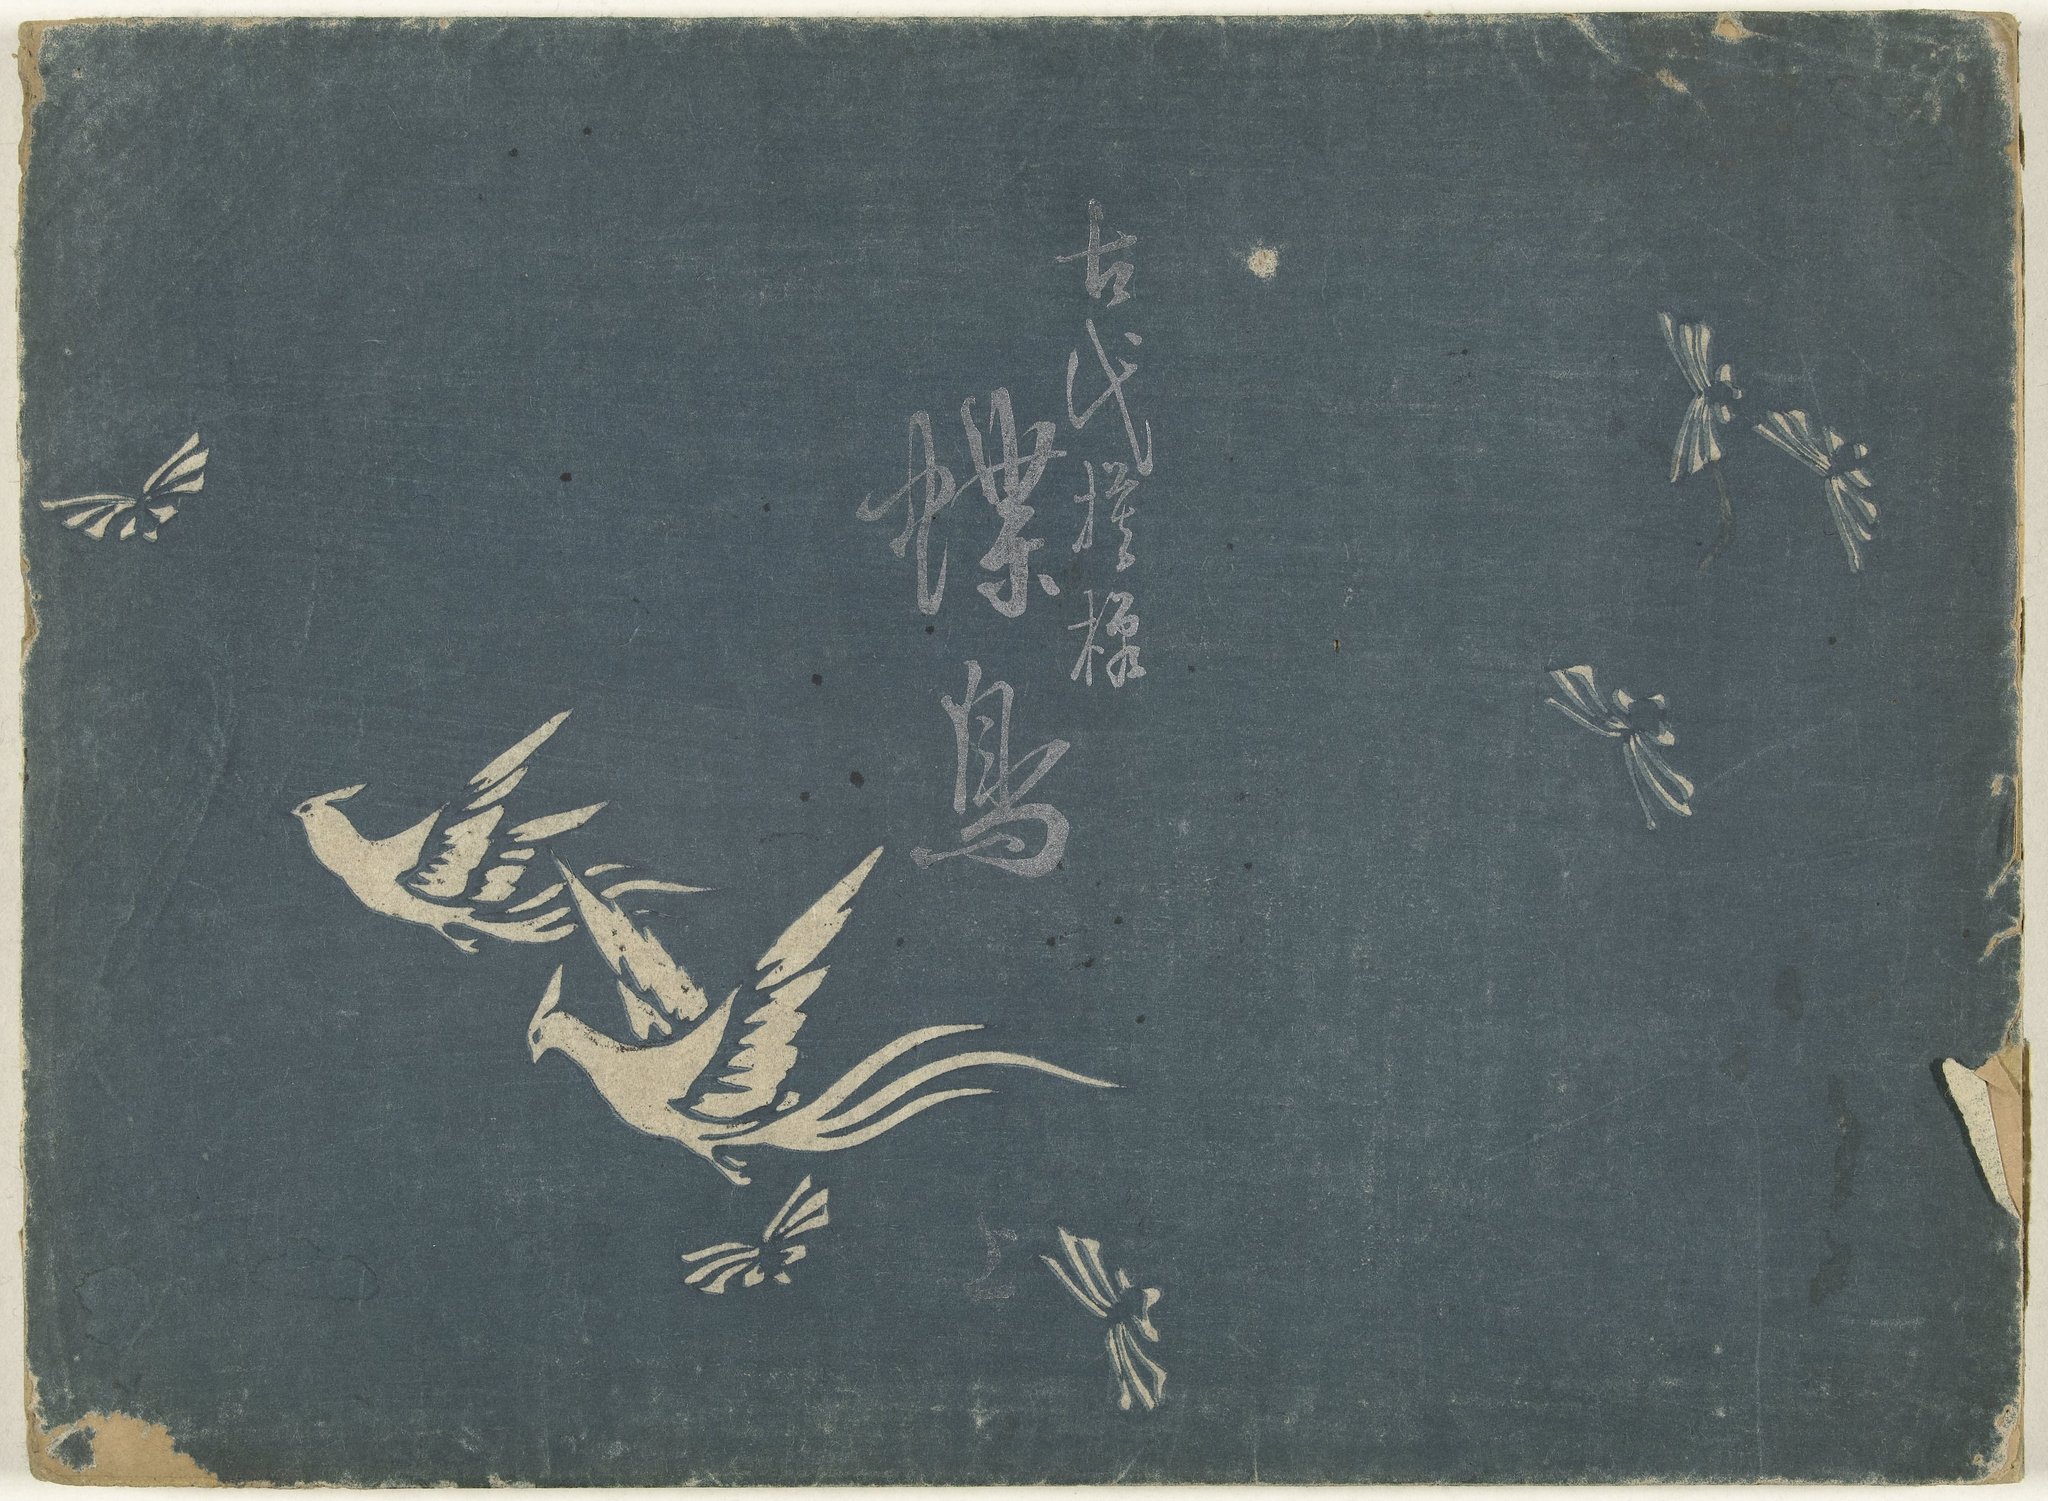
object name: book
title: Vogels en vlinders- deel één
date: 1904-1906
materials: paper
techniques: woodcut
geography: kyoto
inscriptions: date